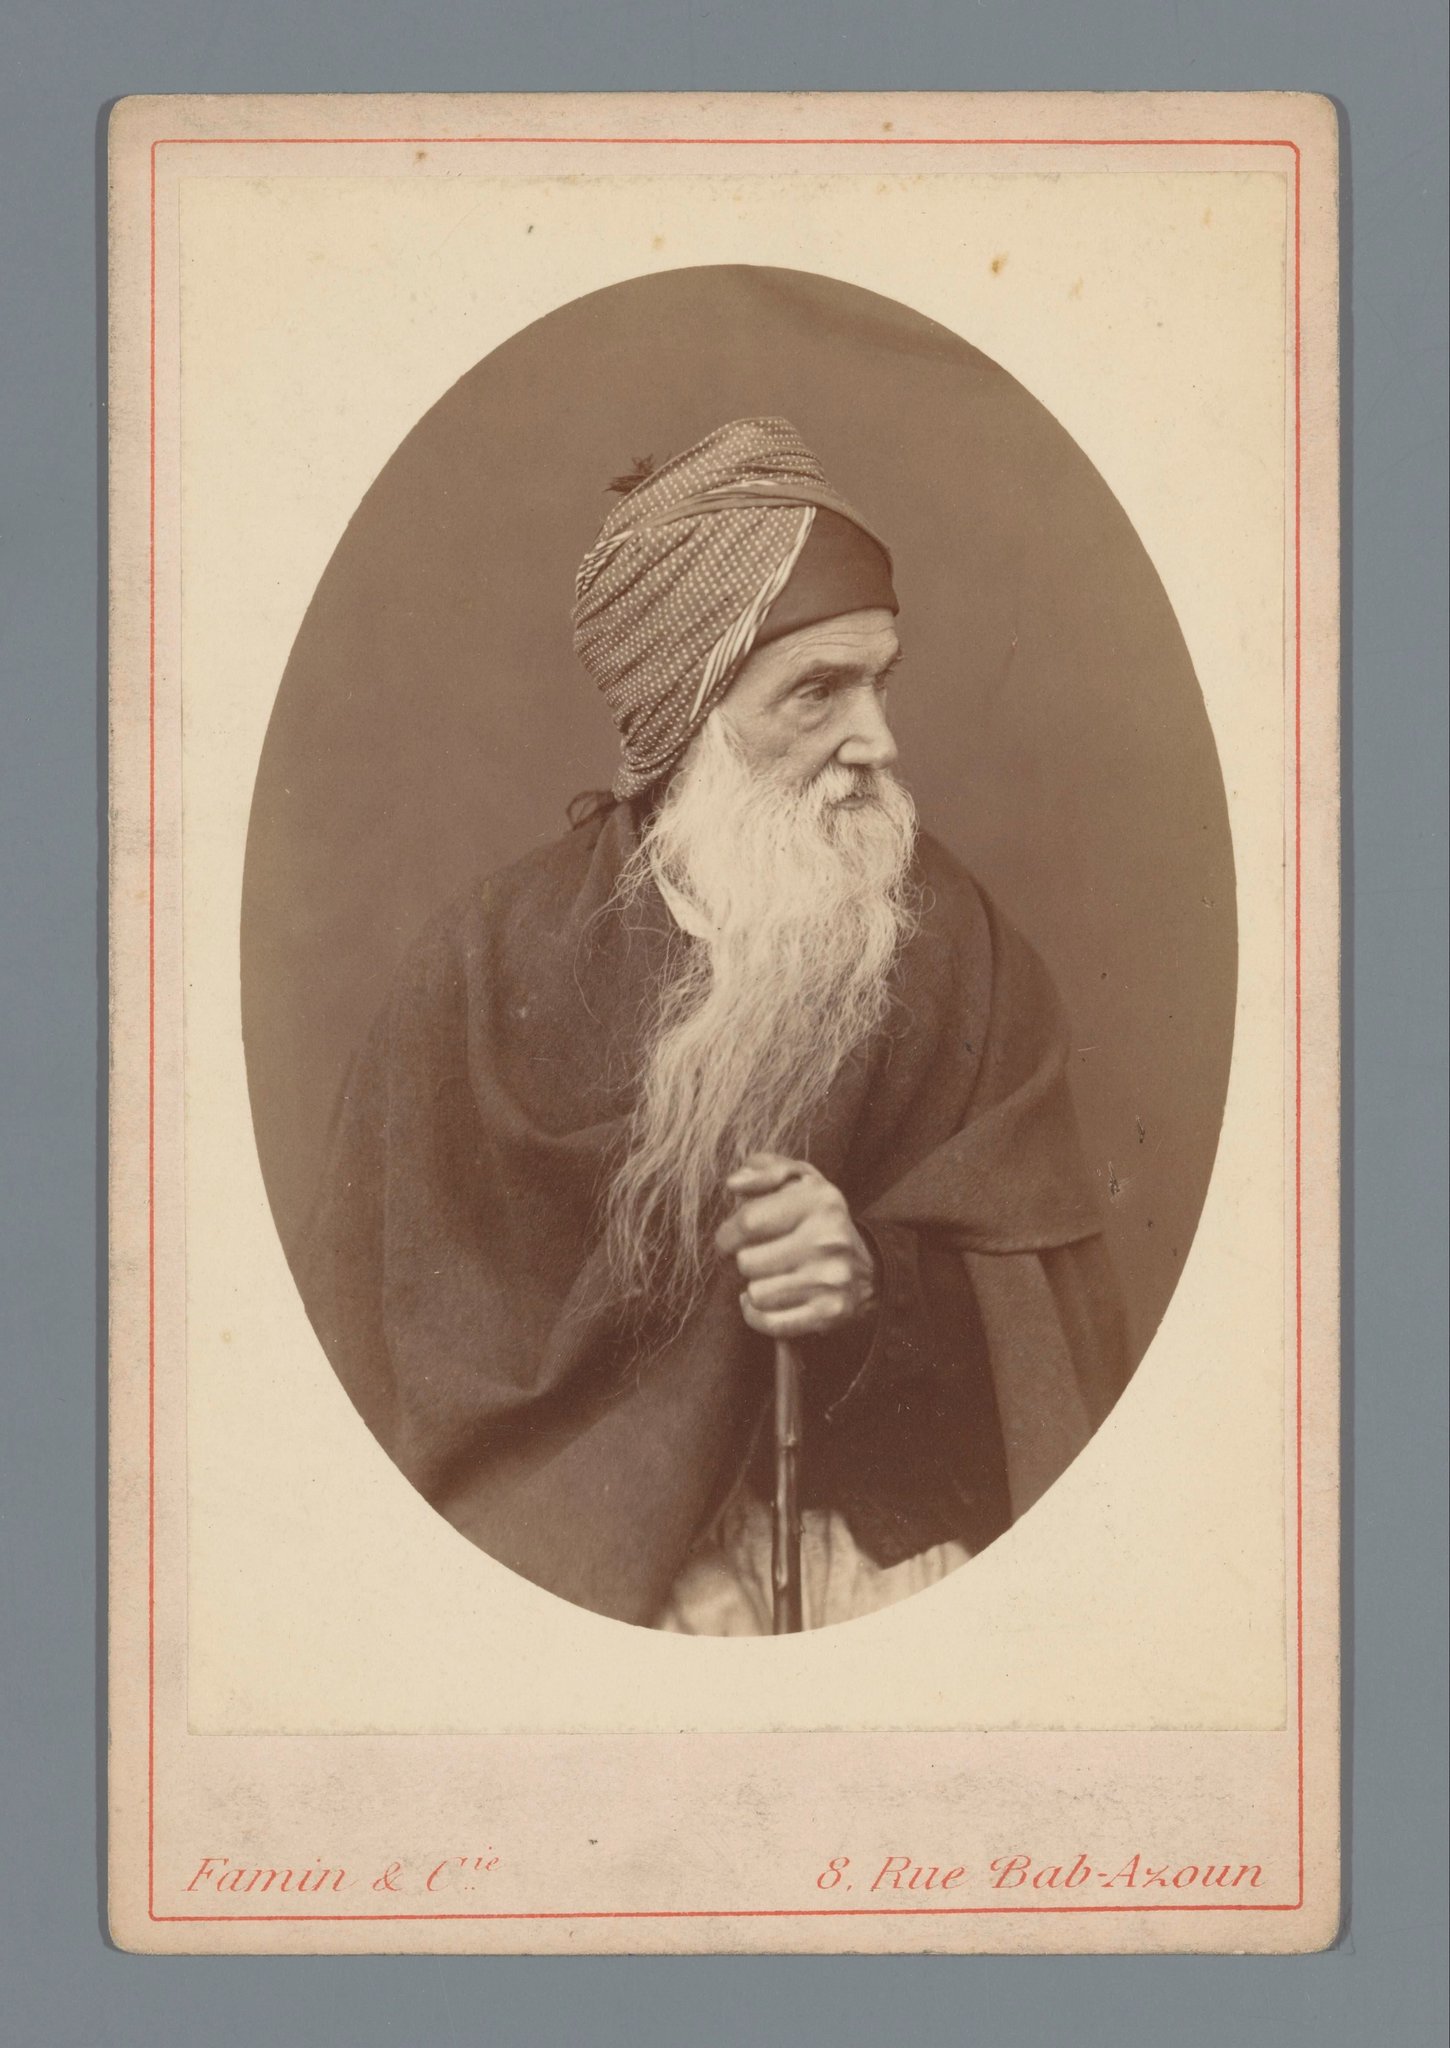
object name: cabinet photograph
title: Portret van een onbekende joodse man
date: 1863-1889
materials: cardboard, photographic support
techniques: albumen print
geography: algeria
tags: anonymous historical person portrayed, jewish religion and culture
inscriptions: inscription: ‘Alger/ 8, Rue Bab-Azoun, 8’, inscription: ‘Juif’, inscription: ‘8, Rue Bab-Azoun’